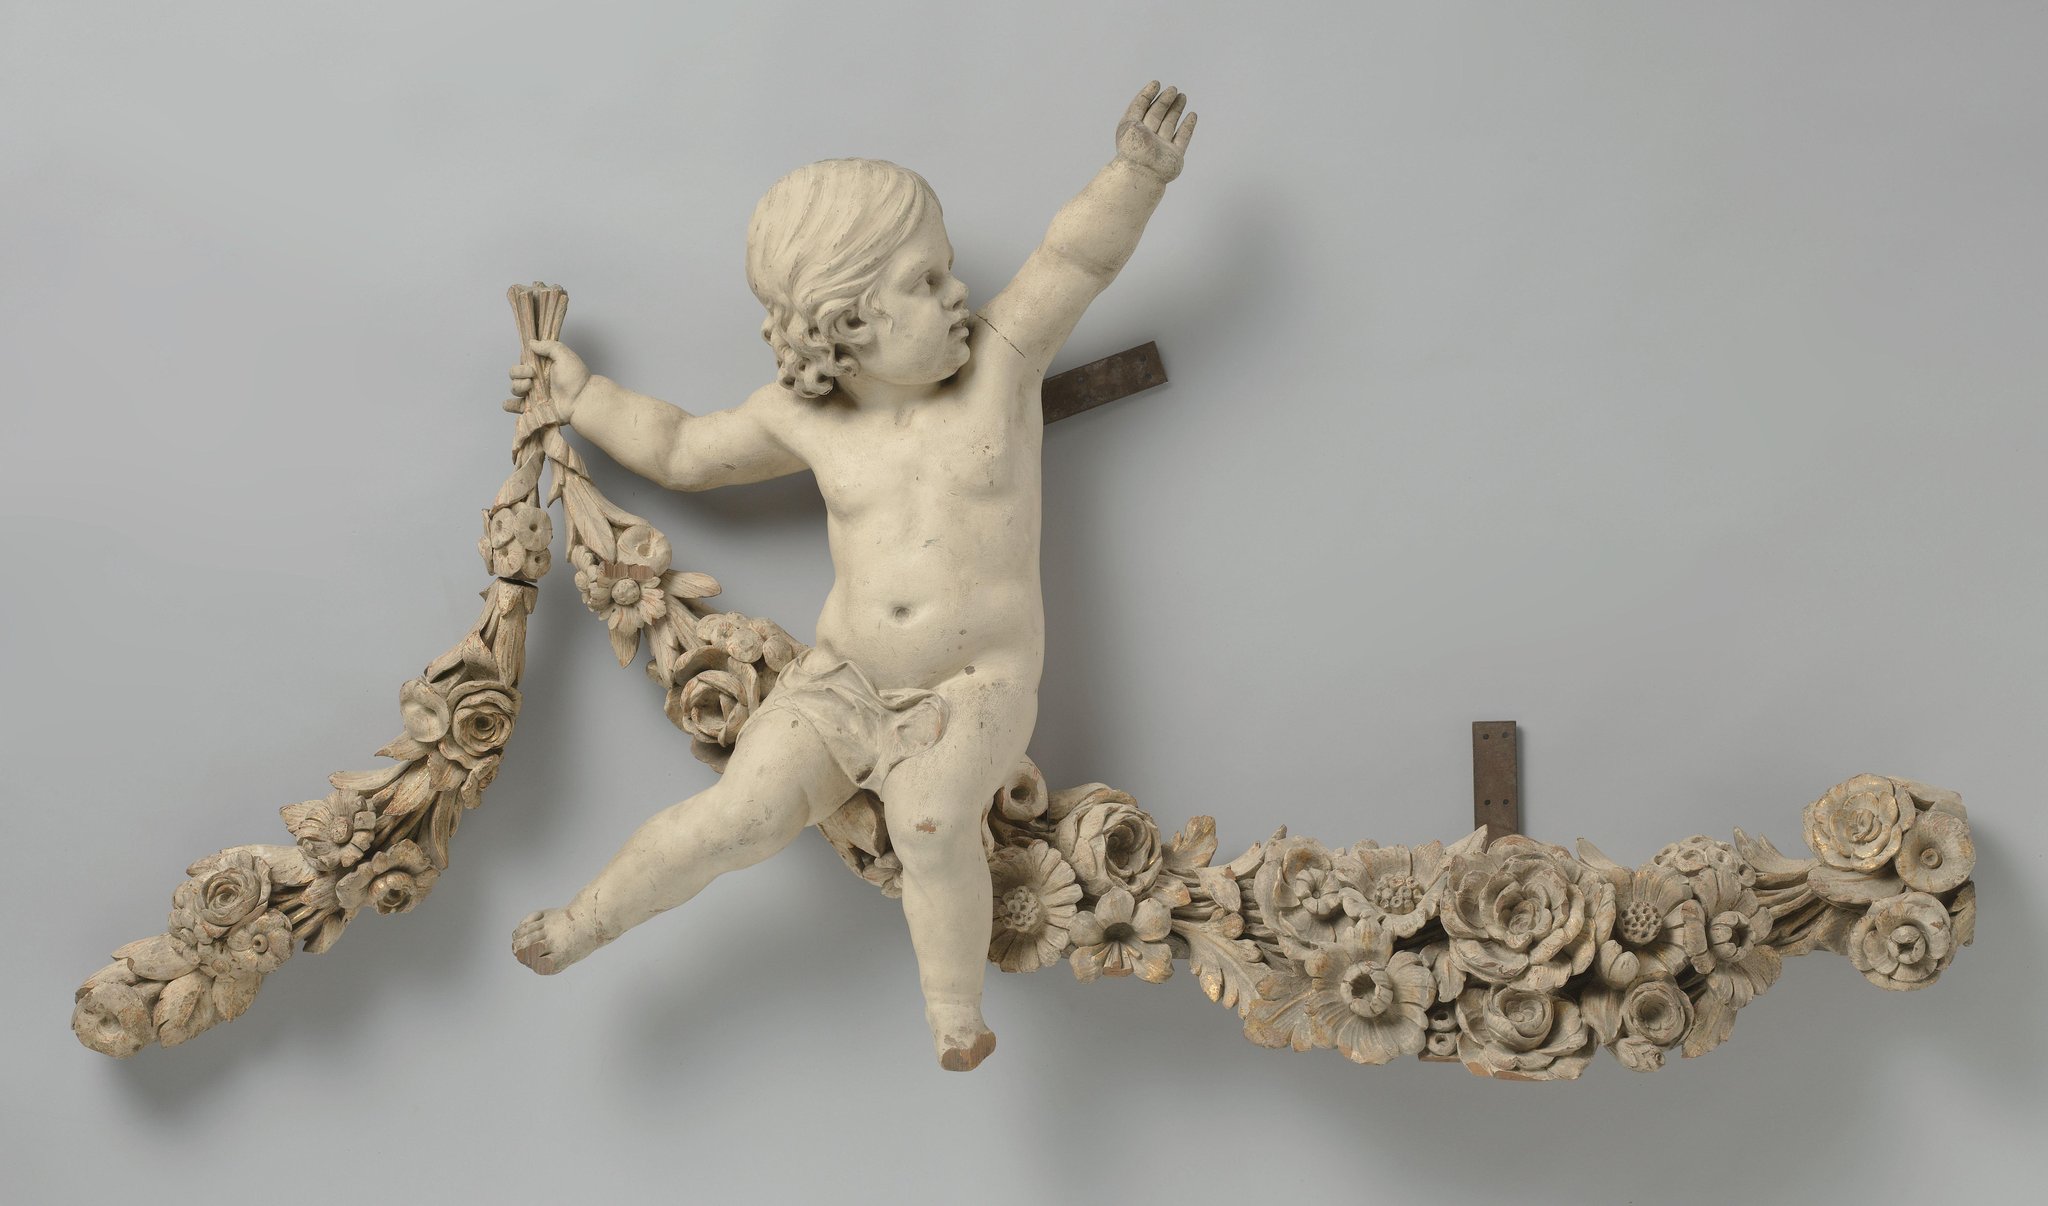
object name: sculpture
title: De vier elementen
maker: michiel emanuel shee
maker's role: sculptor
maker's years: -1740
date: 1730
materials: wood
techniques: cutting, painted